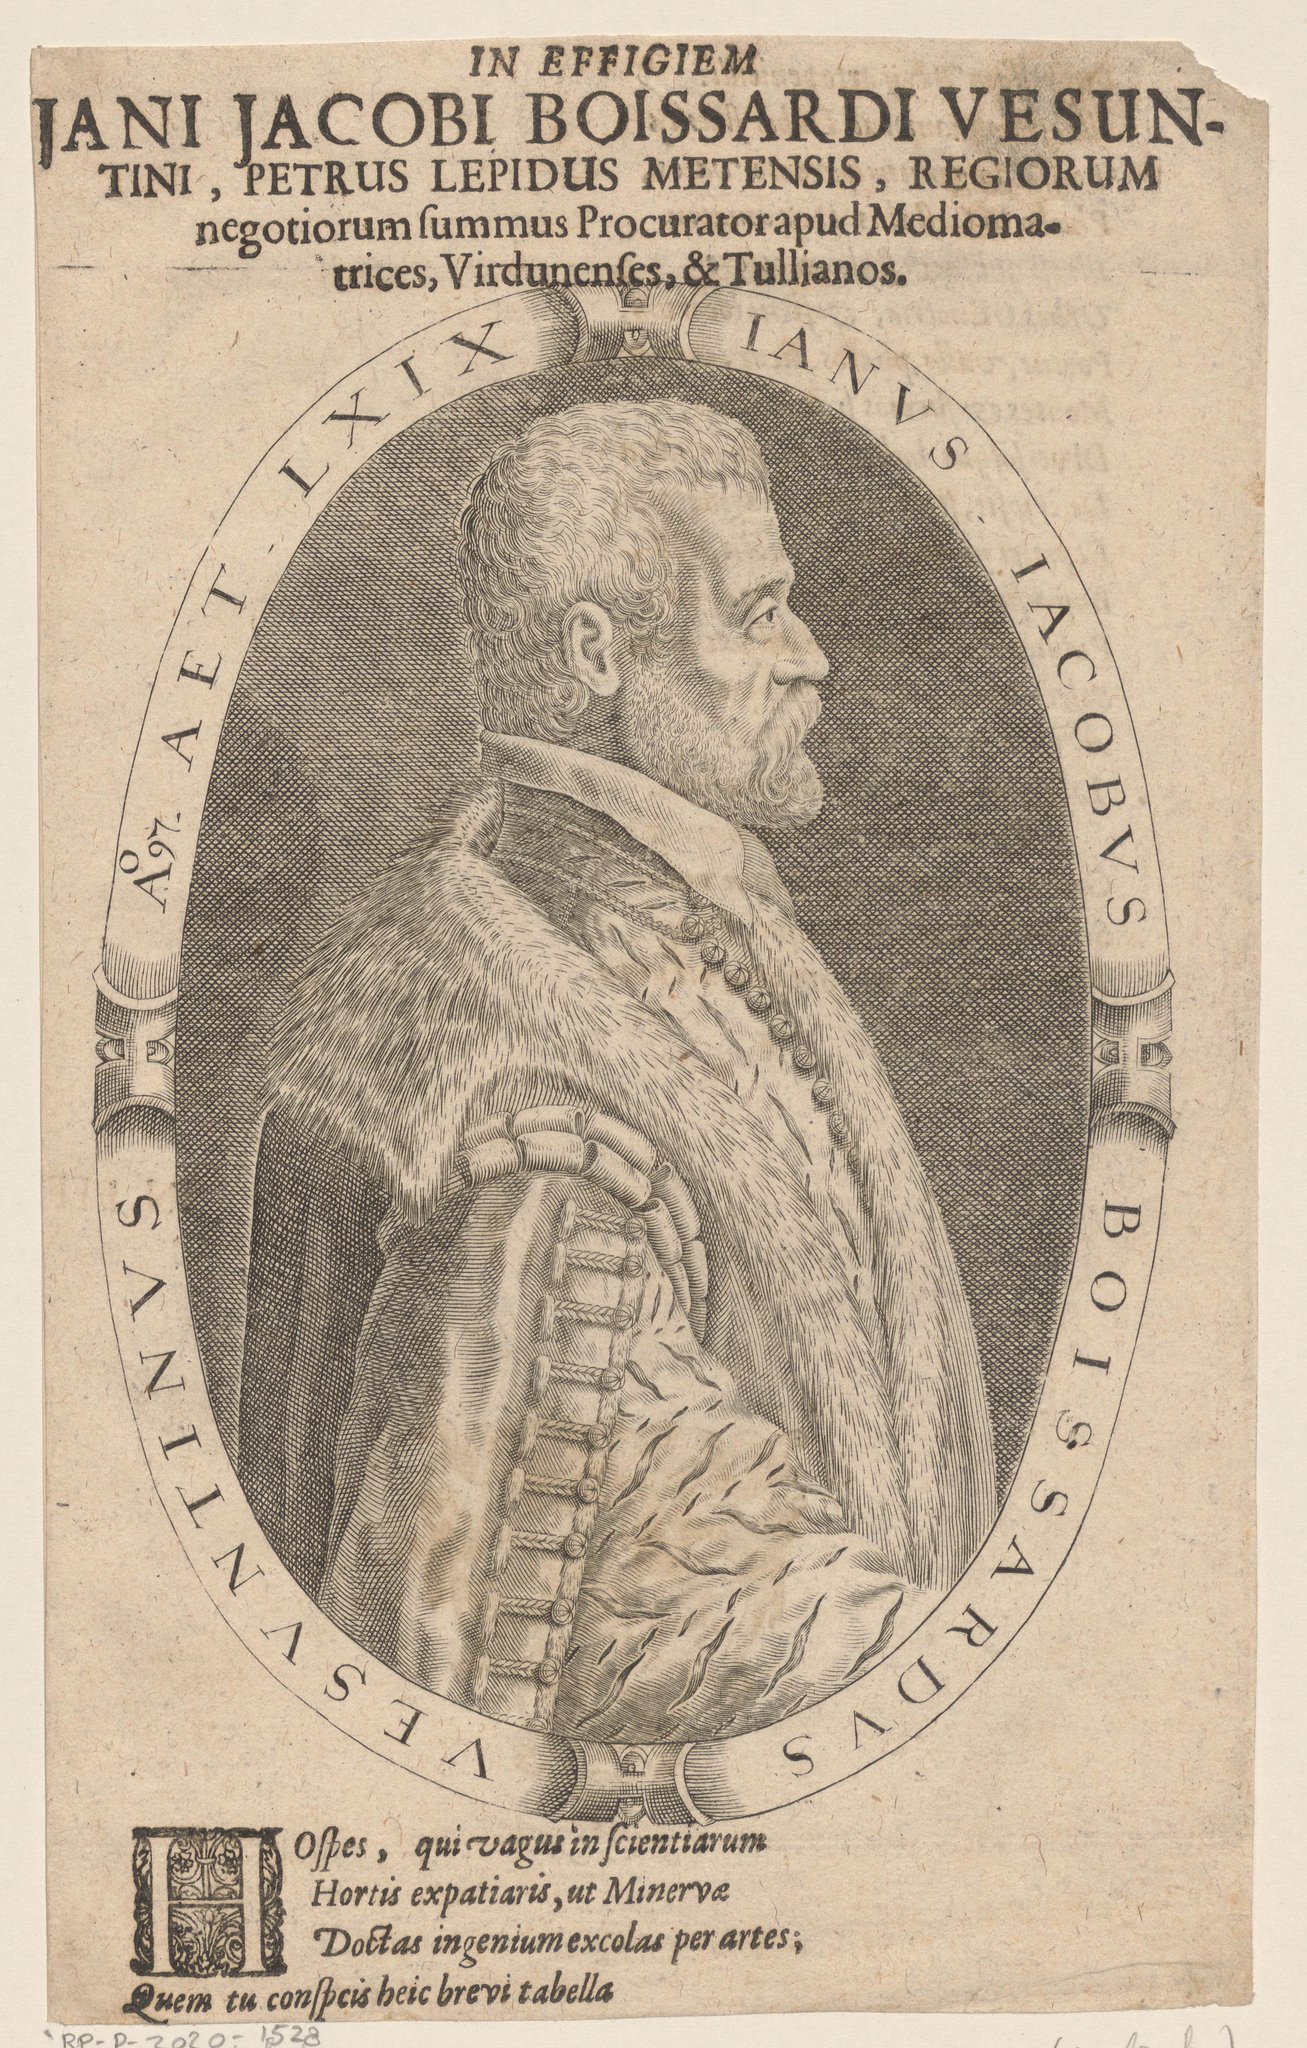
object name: book illustration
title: Portret van Jean Jacques Boissard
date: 1597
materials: paper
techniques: engraving, letterpress printing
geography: frankfurt am main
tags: jean jacques boissard, historical persons, portrait of a writer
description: Prent uit: Boissard, Jean Jacques. Antiquitatum seu inscriptionum & epitaphiorum quae in saxi & marmoribus Romanis videntur (...). Frankfurt am Main: Theodor de Bry, 1597, dl. 3. Prent ook gebruikt in andere publicaties.